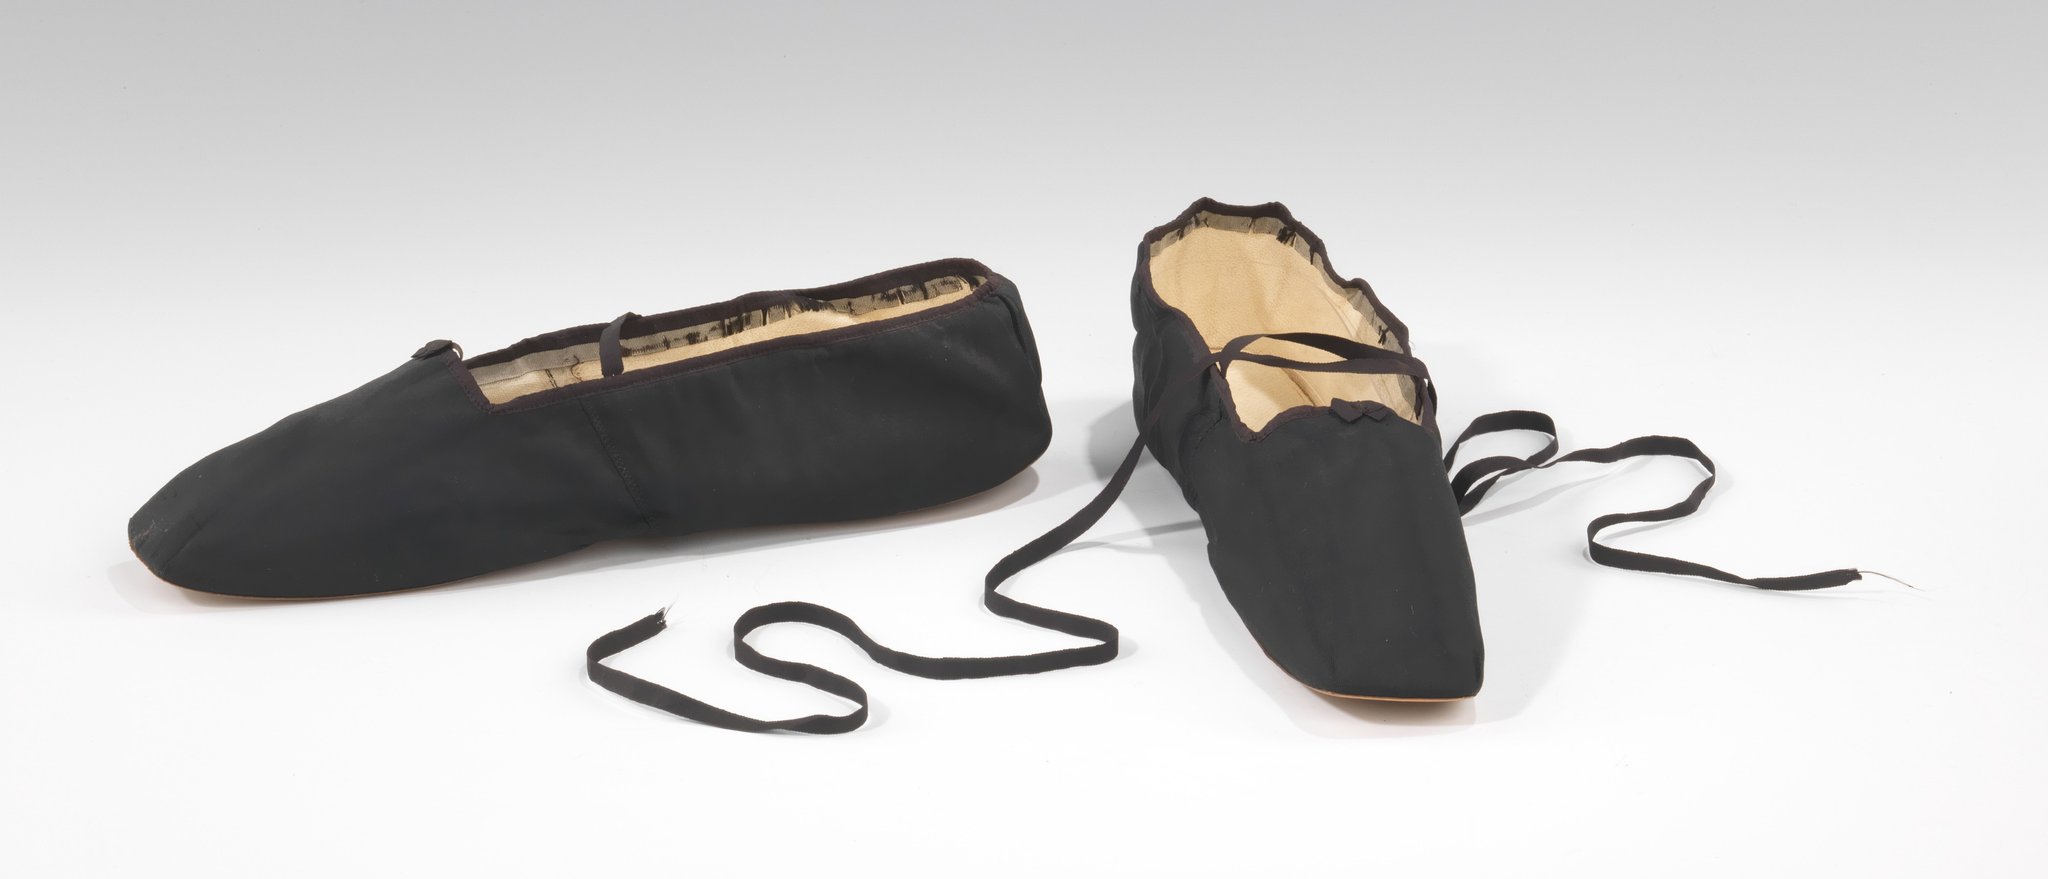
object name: evening slipper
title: Evening slippers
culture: french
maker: melnotte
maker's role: designer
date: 1845-1865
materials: silk